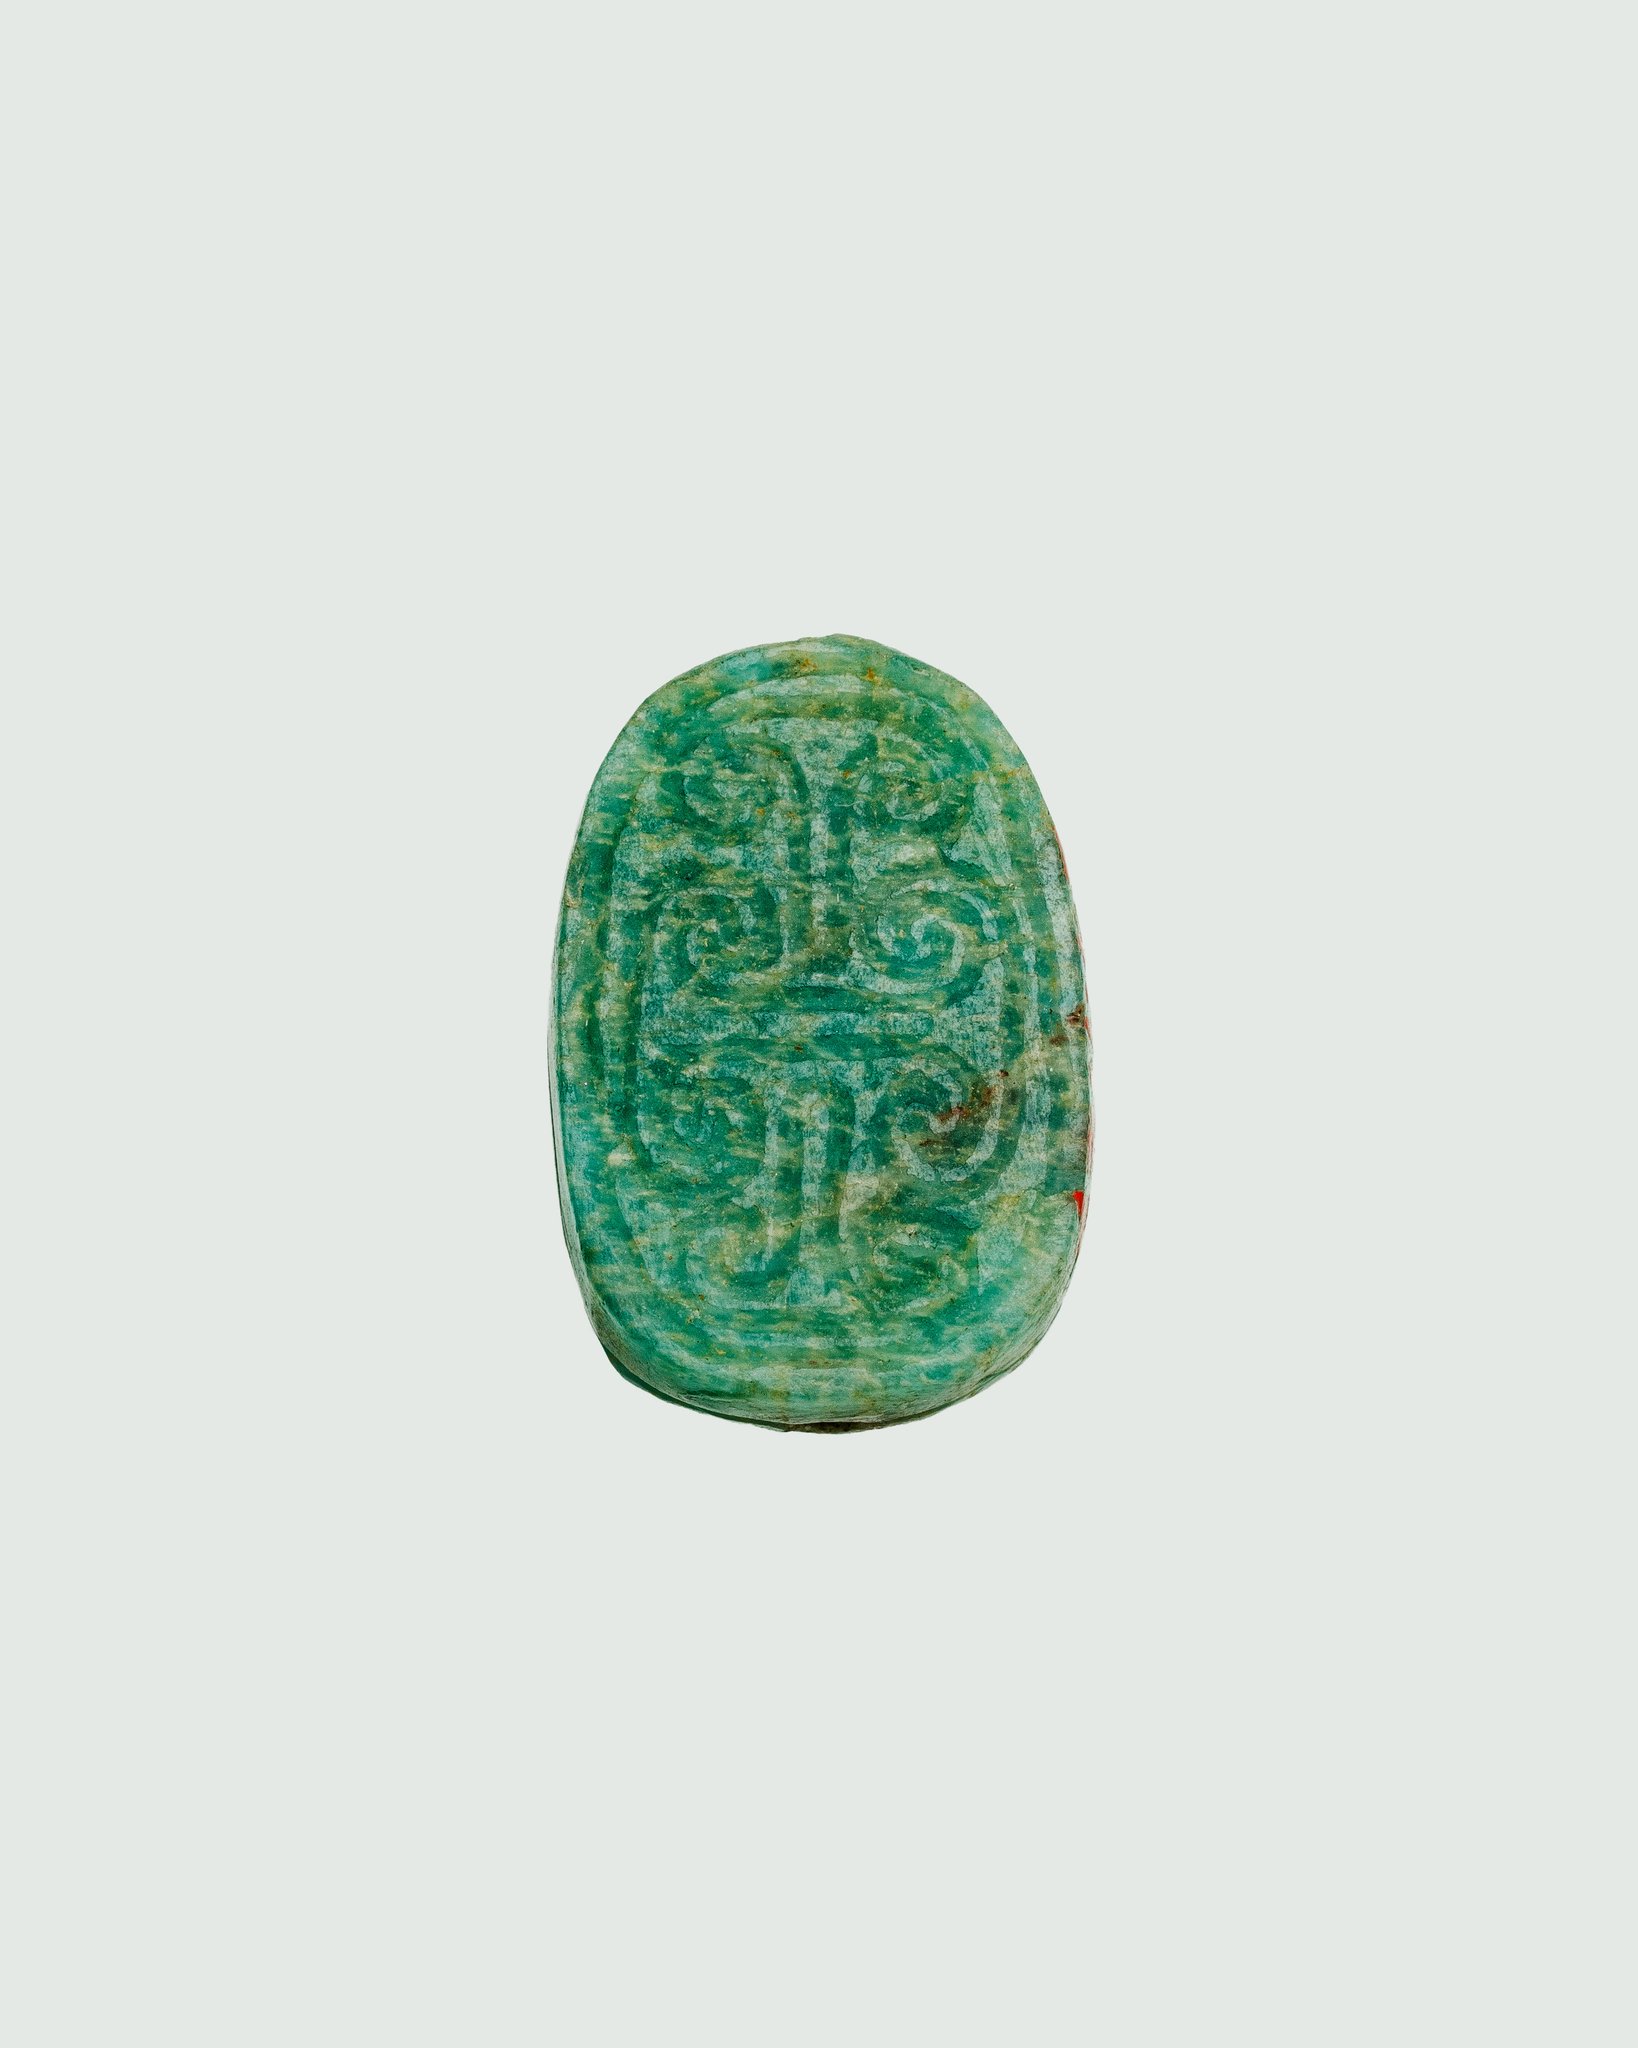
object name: scarab, scroll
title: Scarab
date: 1981-1802 BCE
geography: egypt